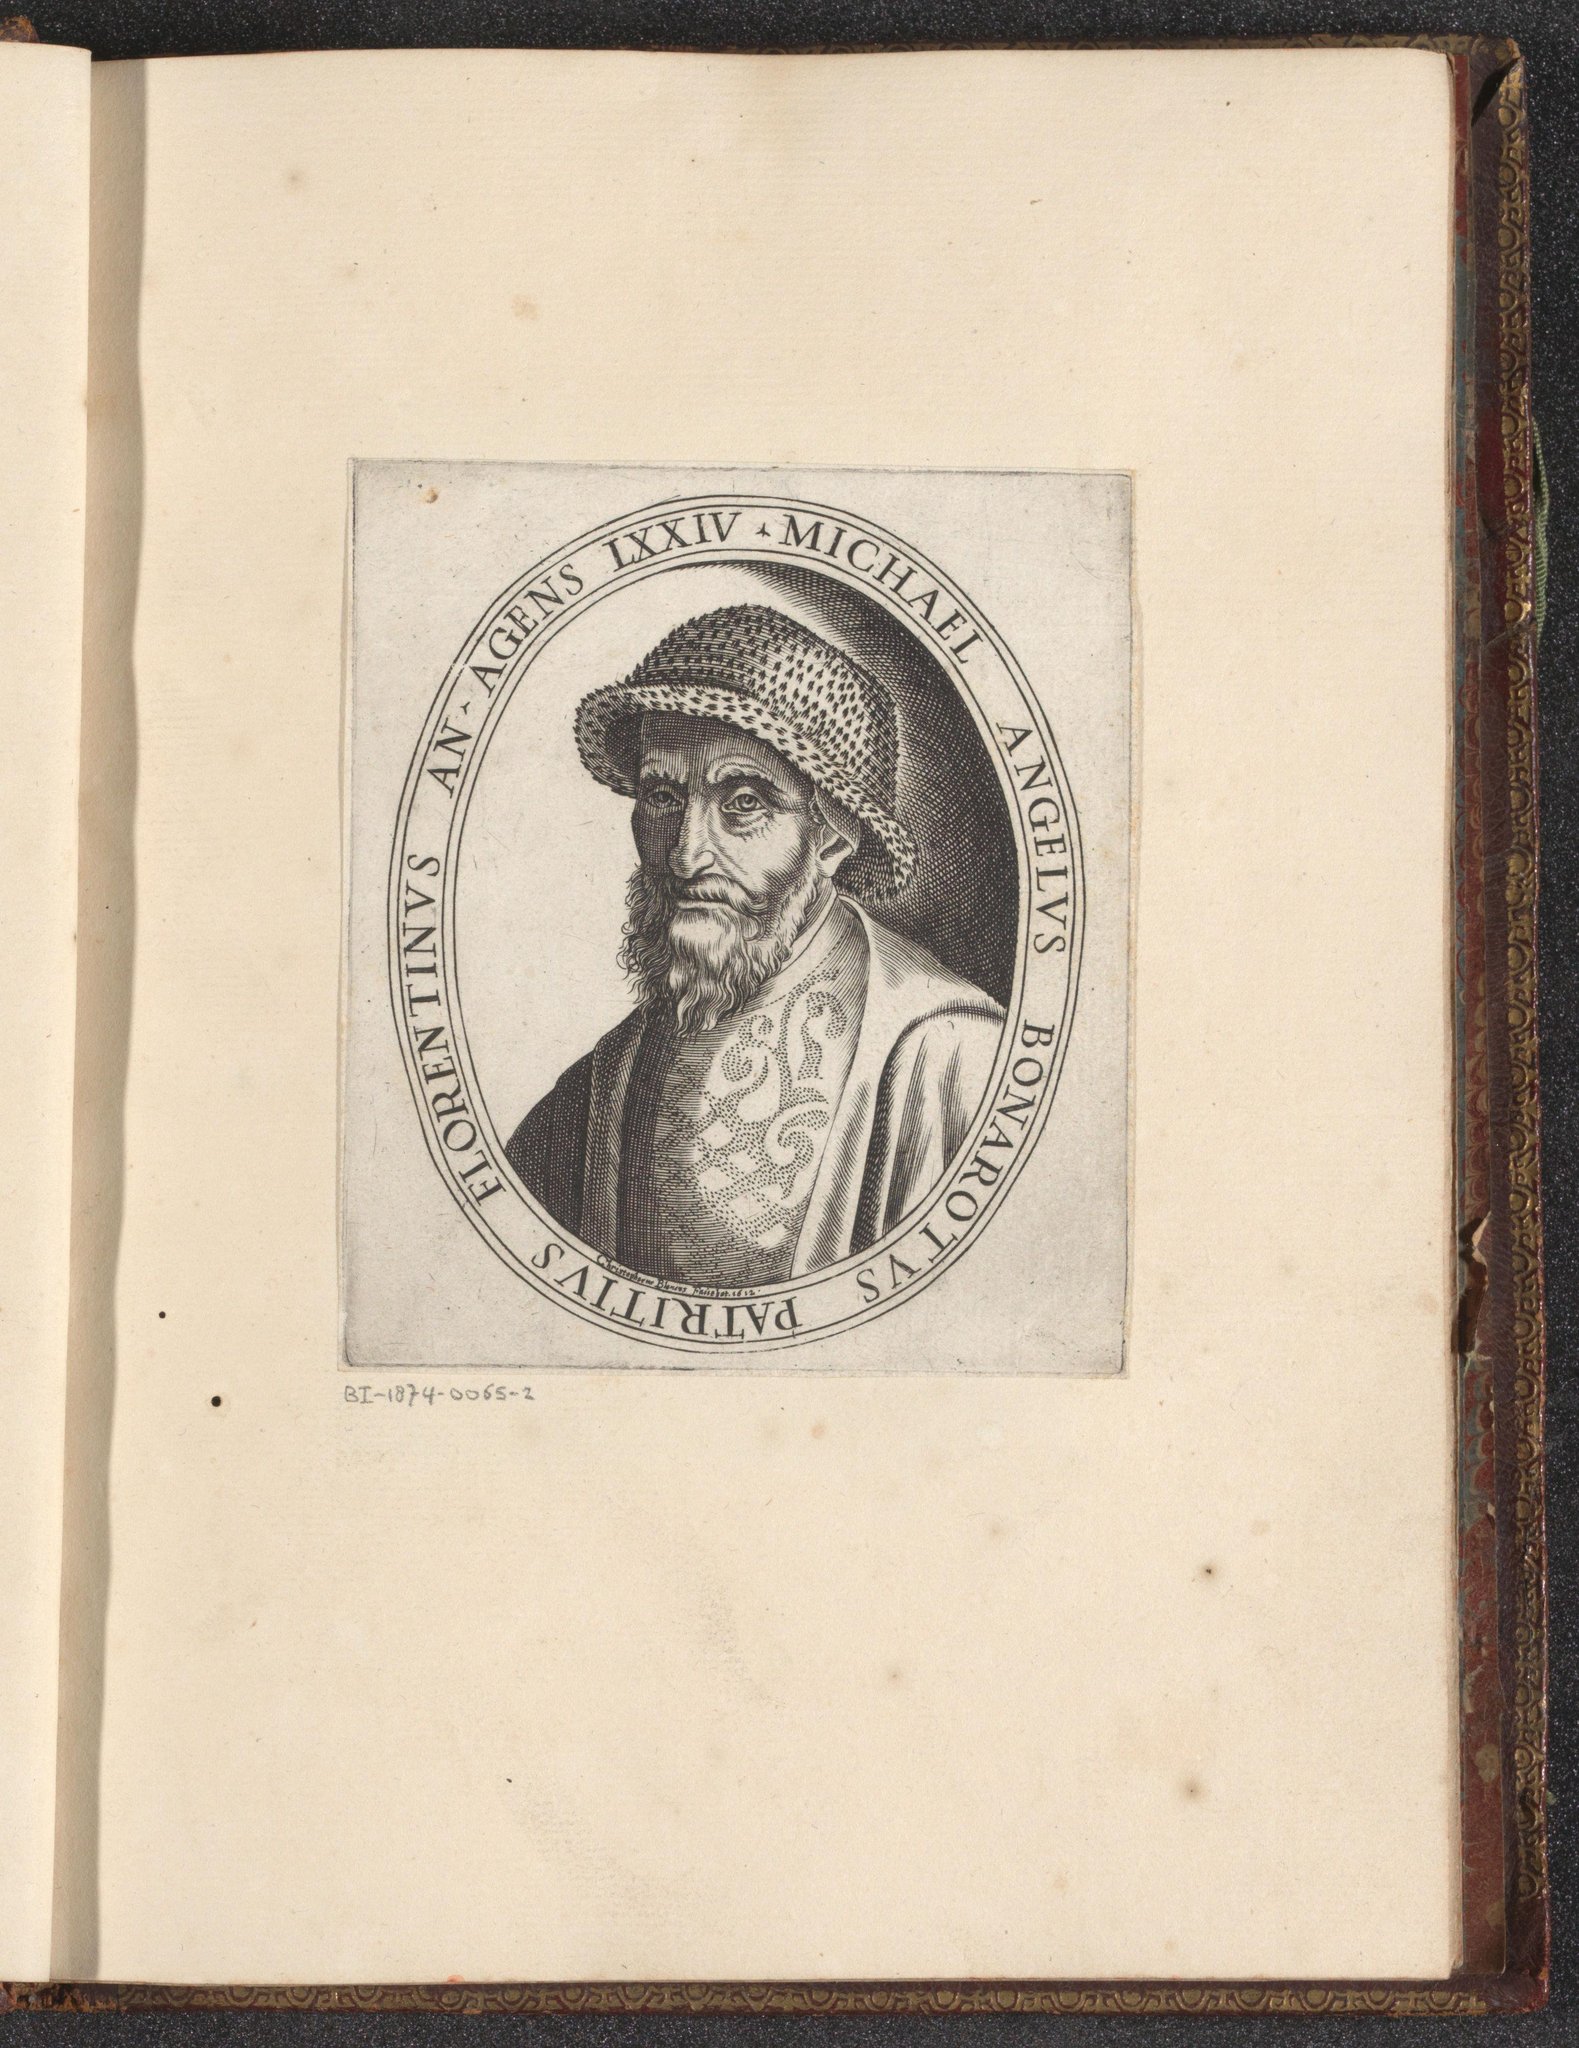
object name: print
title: Portret van kunstenaar Michelangelo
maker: christoforo blanco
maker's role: printer, publisher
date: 1612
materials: paper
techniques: engraving, intaglio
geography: italy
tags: rome, painter, draughtsman, sculptor, michelangelo, portrait, self-portrait of artist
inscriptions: date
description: Deze prent maakt deel uit van een serie bestaande uit een titelprent en 72 prenten naar schilderingen door Michelangelo in de Sixtijnse Kapel in het Vaticaan.